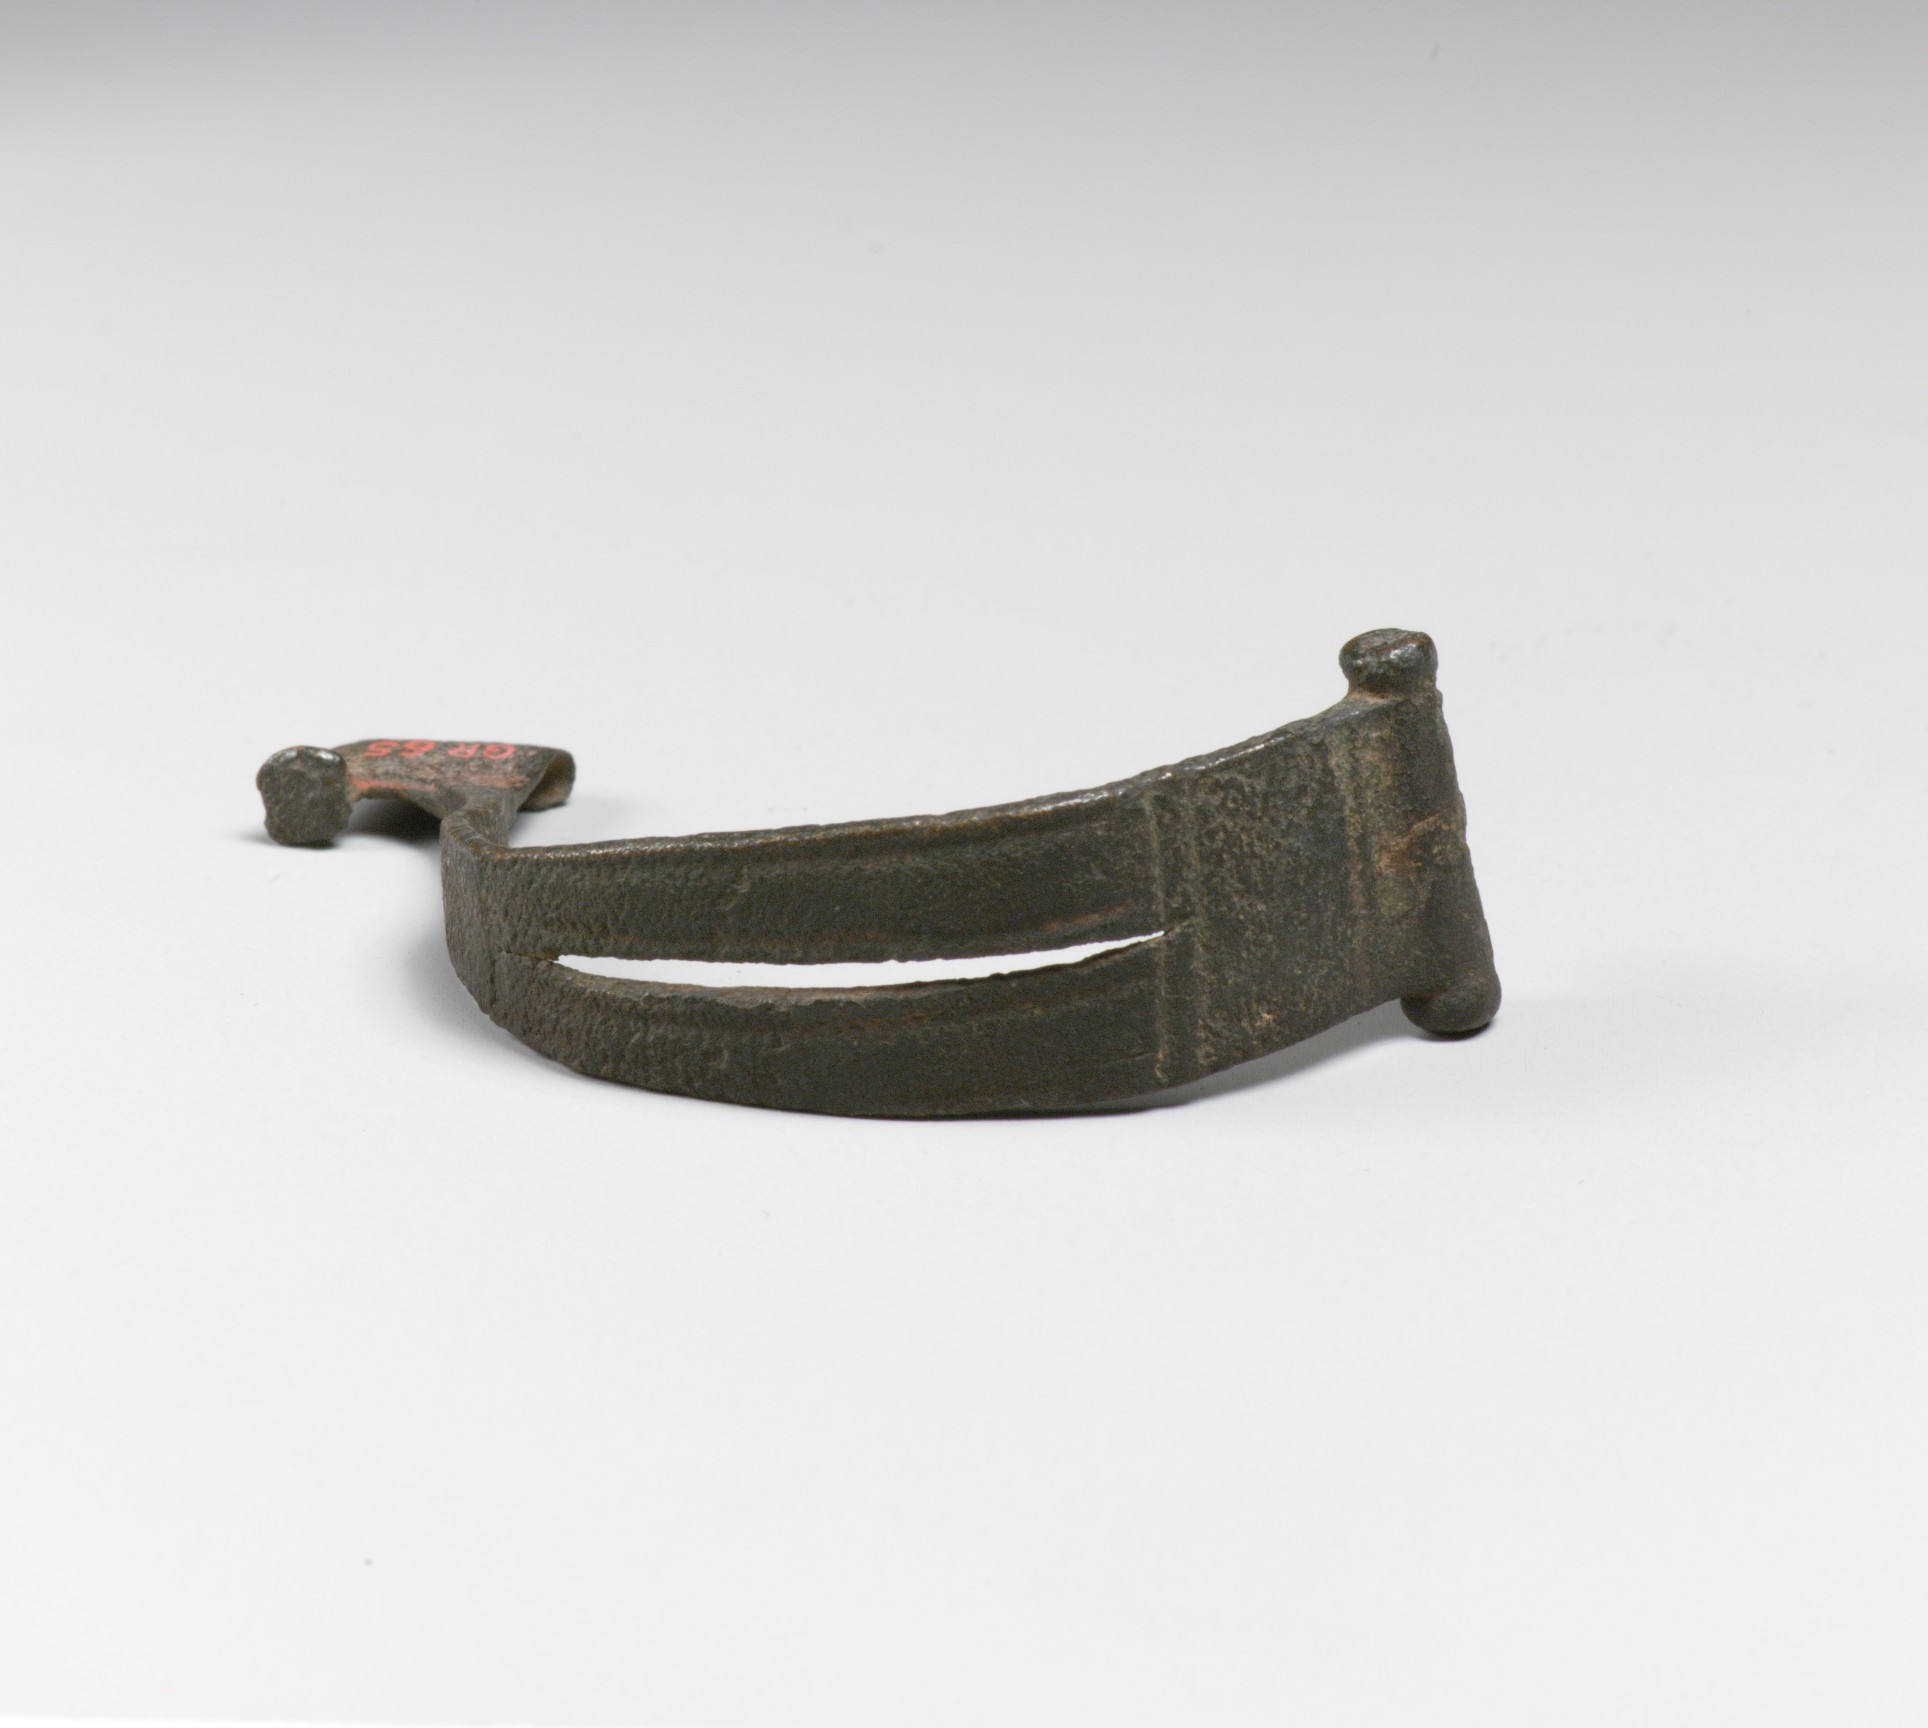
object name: fibula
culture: imperial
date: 201-400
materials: bronze